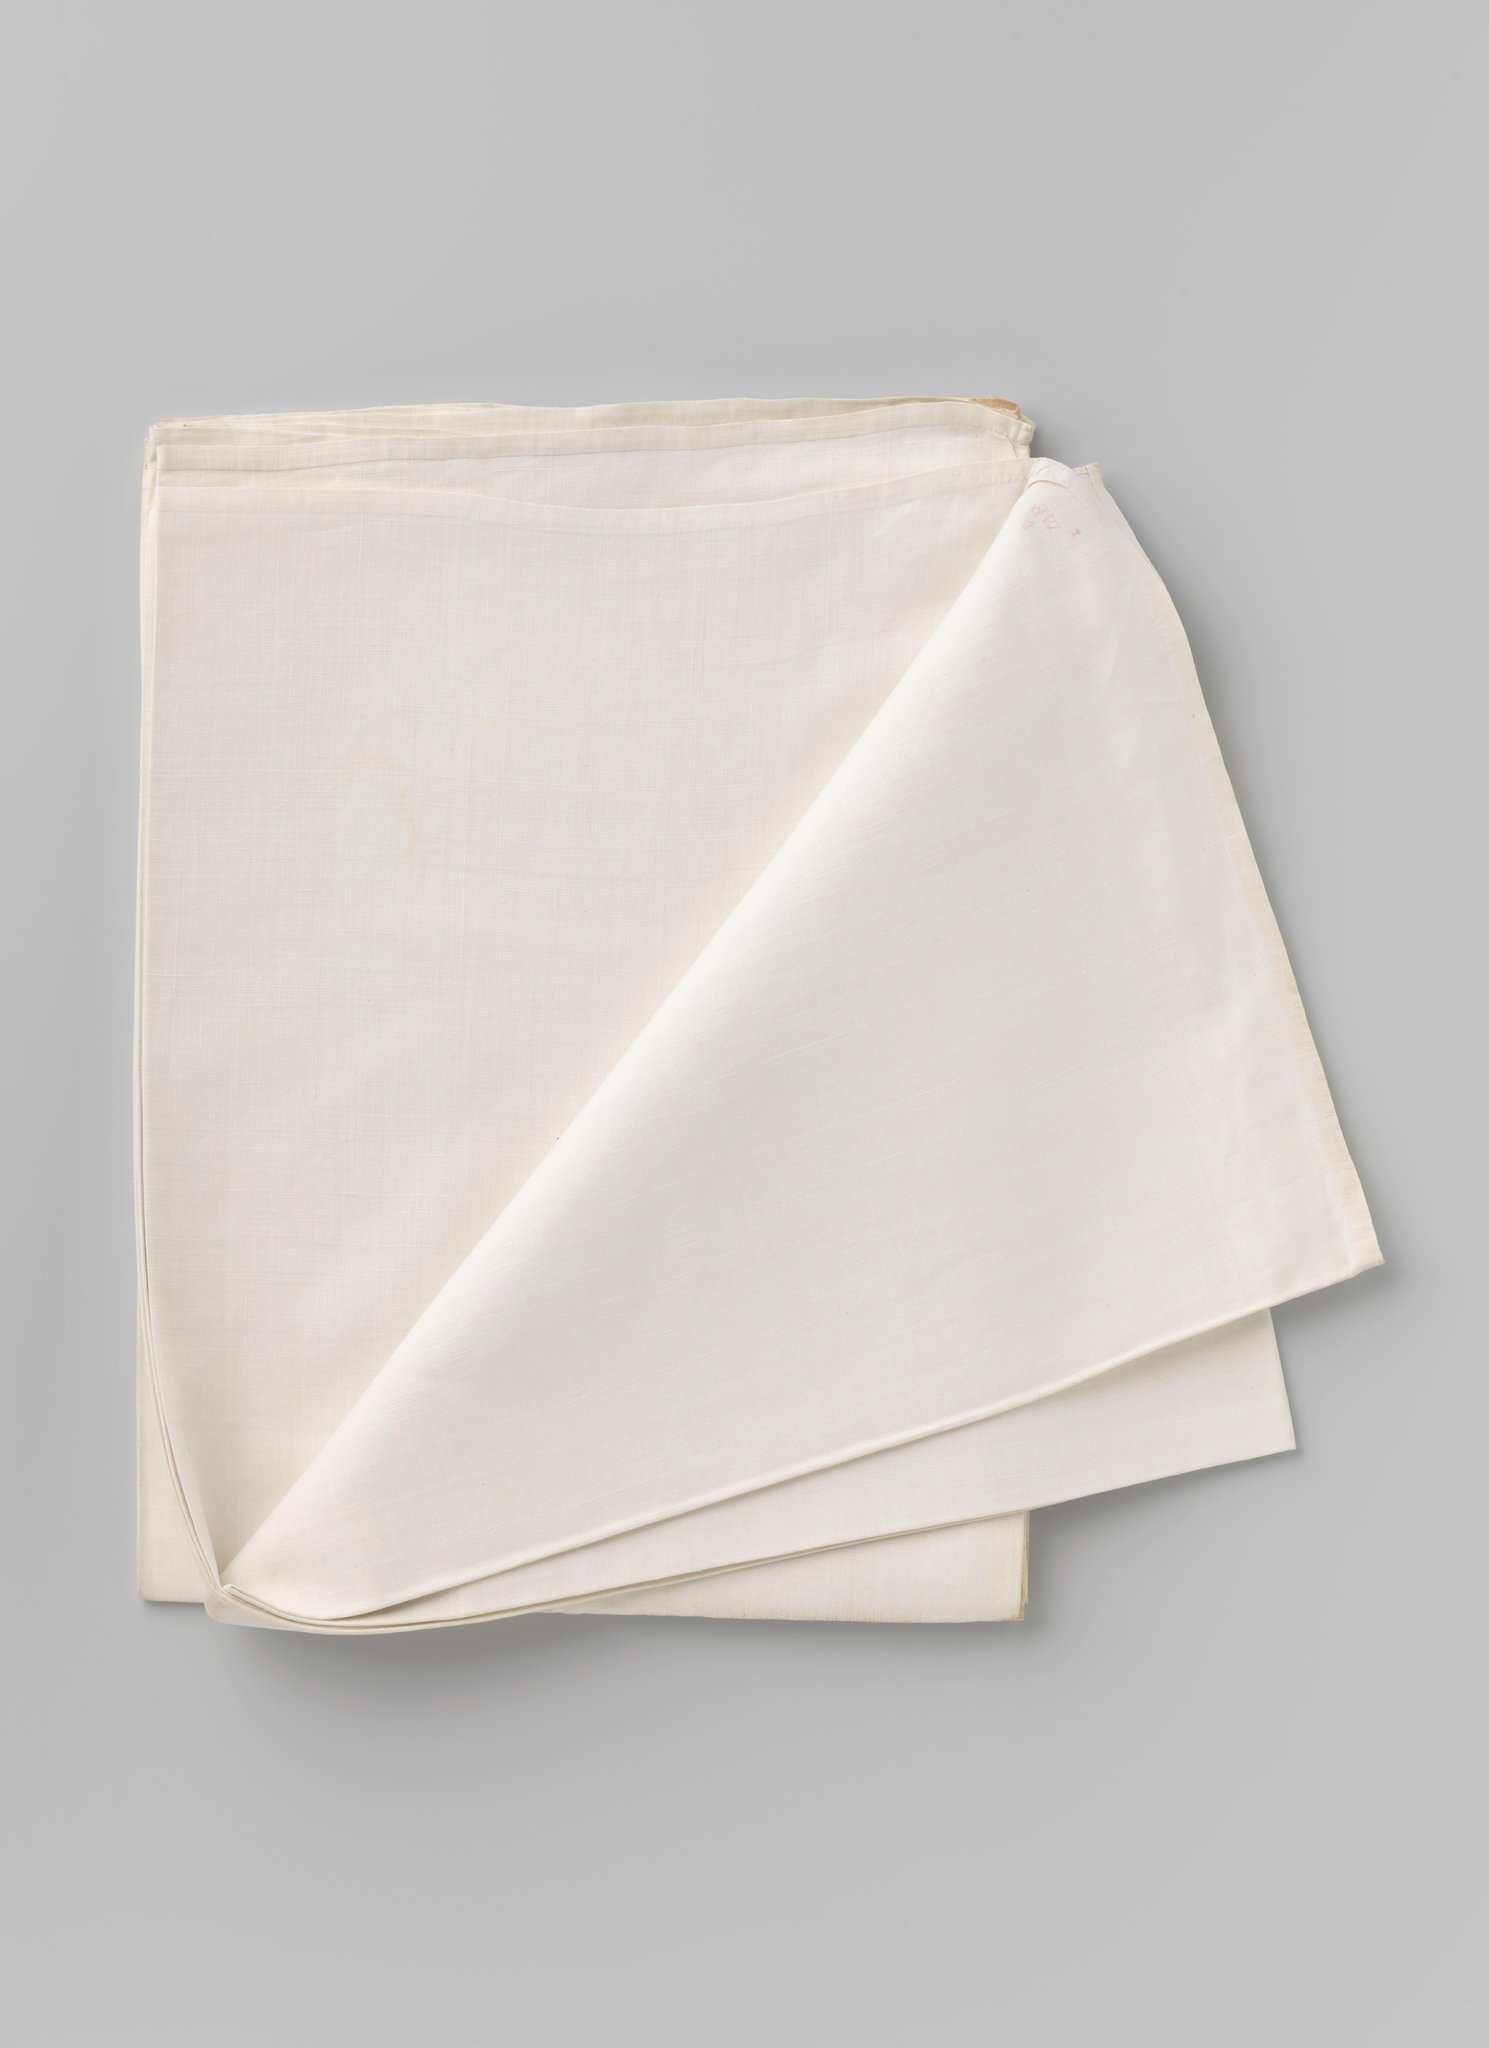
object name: beddenlaken, laken object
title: Laken. Merk: HW34.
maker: Anonymous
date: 1700-1800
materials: linen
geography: northern netherlands